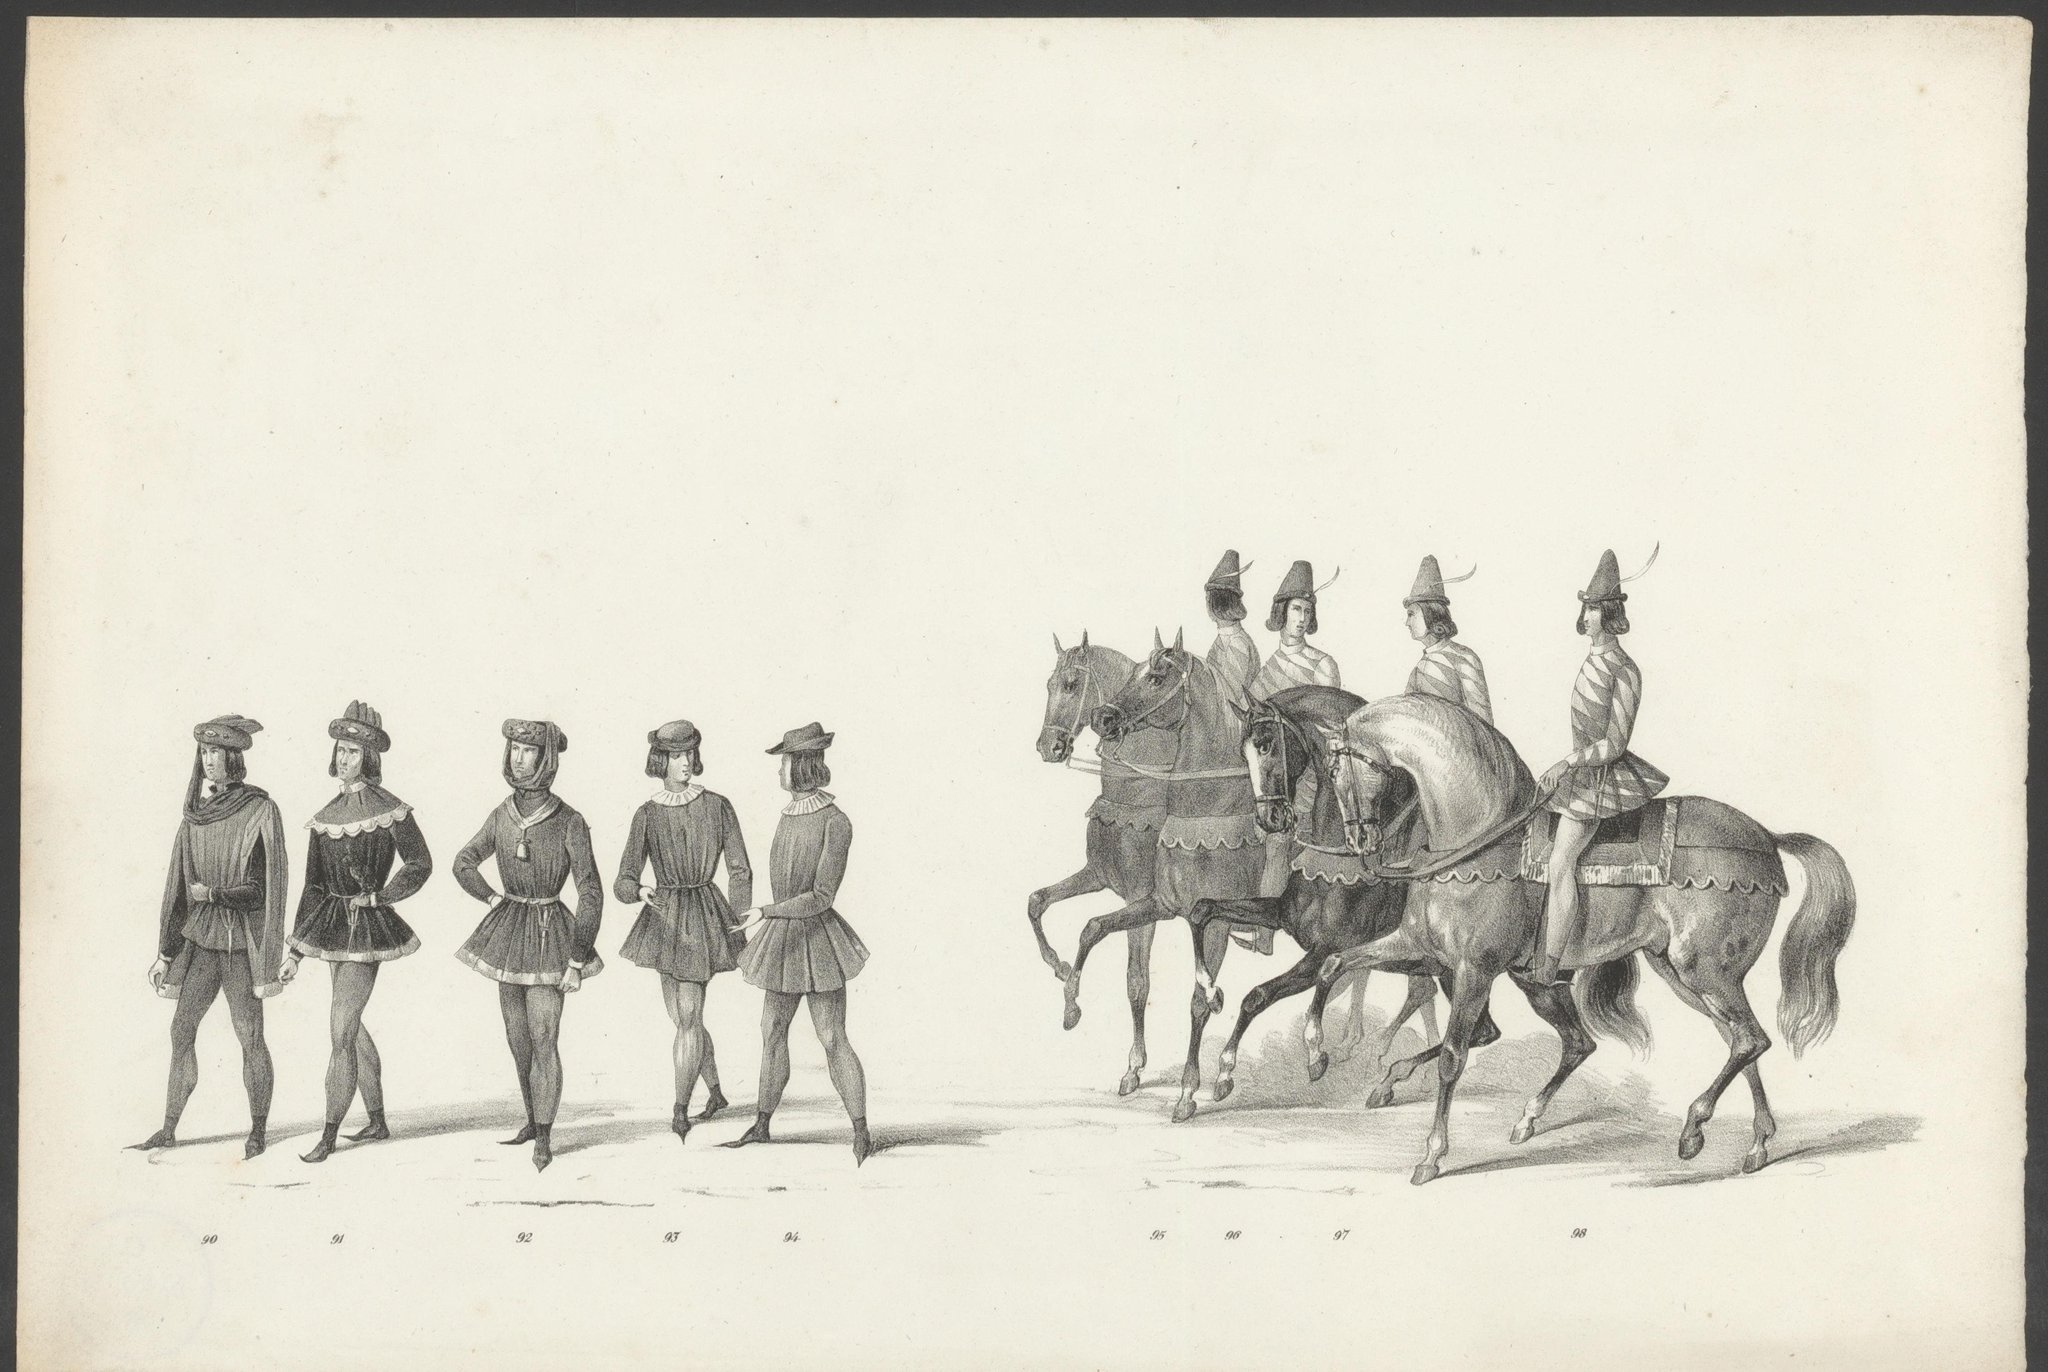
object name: print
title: De intogt van Hertog Jan van Beijeren binnen Leyden. Op den 18den Augustus 1420 in Maskerade voorgesteld door H.H. Studenten der Leydsche Hoogeschool, Op den 8sten Februarij 1840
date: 1840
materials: paper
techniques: lithograph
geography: leiden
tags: jan van beieren, students' pageant, triumphal entry and public reception, pageant, 'entrée solennelle', 'joyeuse entrée'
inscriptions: collector's mark: Lugt 1641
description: Ridders en stalmeesters van de hertog te paard. Historische gekostumeerde optocht van de studenten van de Hogeschool van Leiden op 8 februari 1840. De optocht verbeeldt de intocht van hertog Jan van Beieren te Leiden op 18 augustus 1420. Onderaan genummerd: 90 t/m 98. Onderwerpsrubrieken binnen de Atlas Zeden en Gewoonten: Onderwijs en Wetenschappen, Studentenleven.